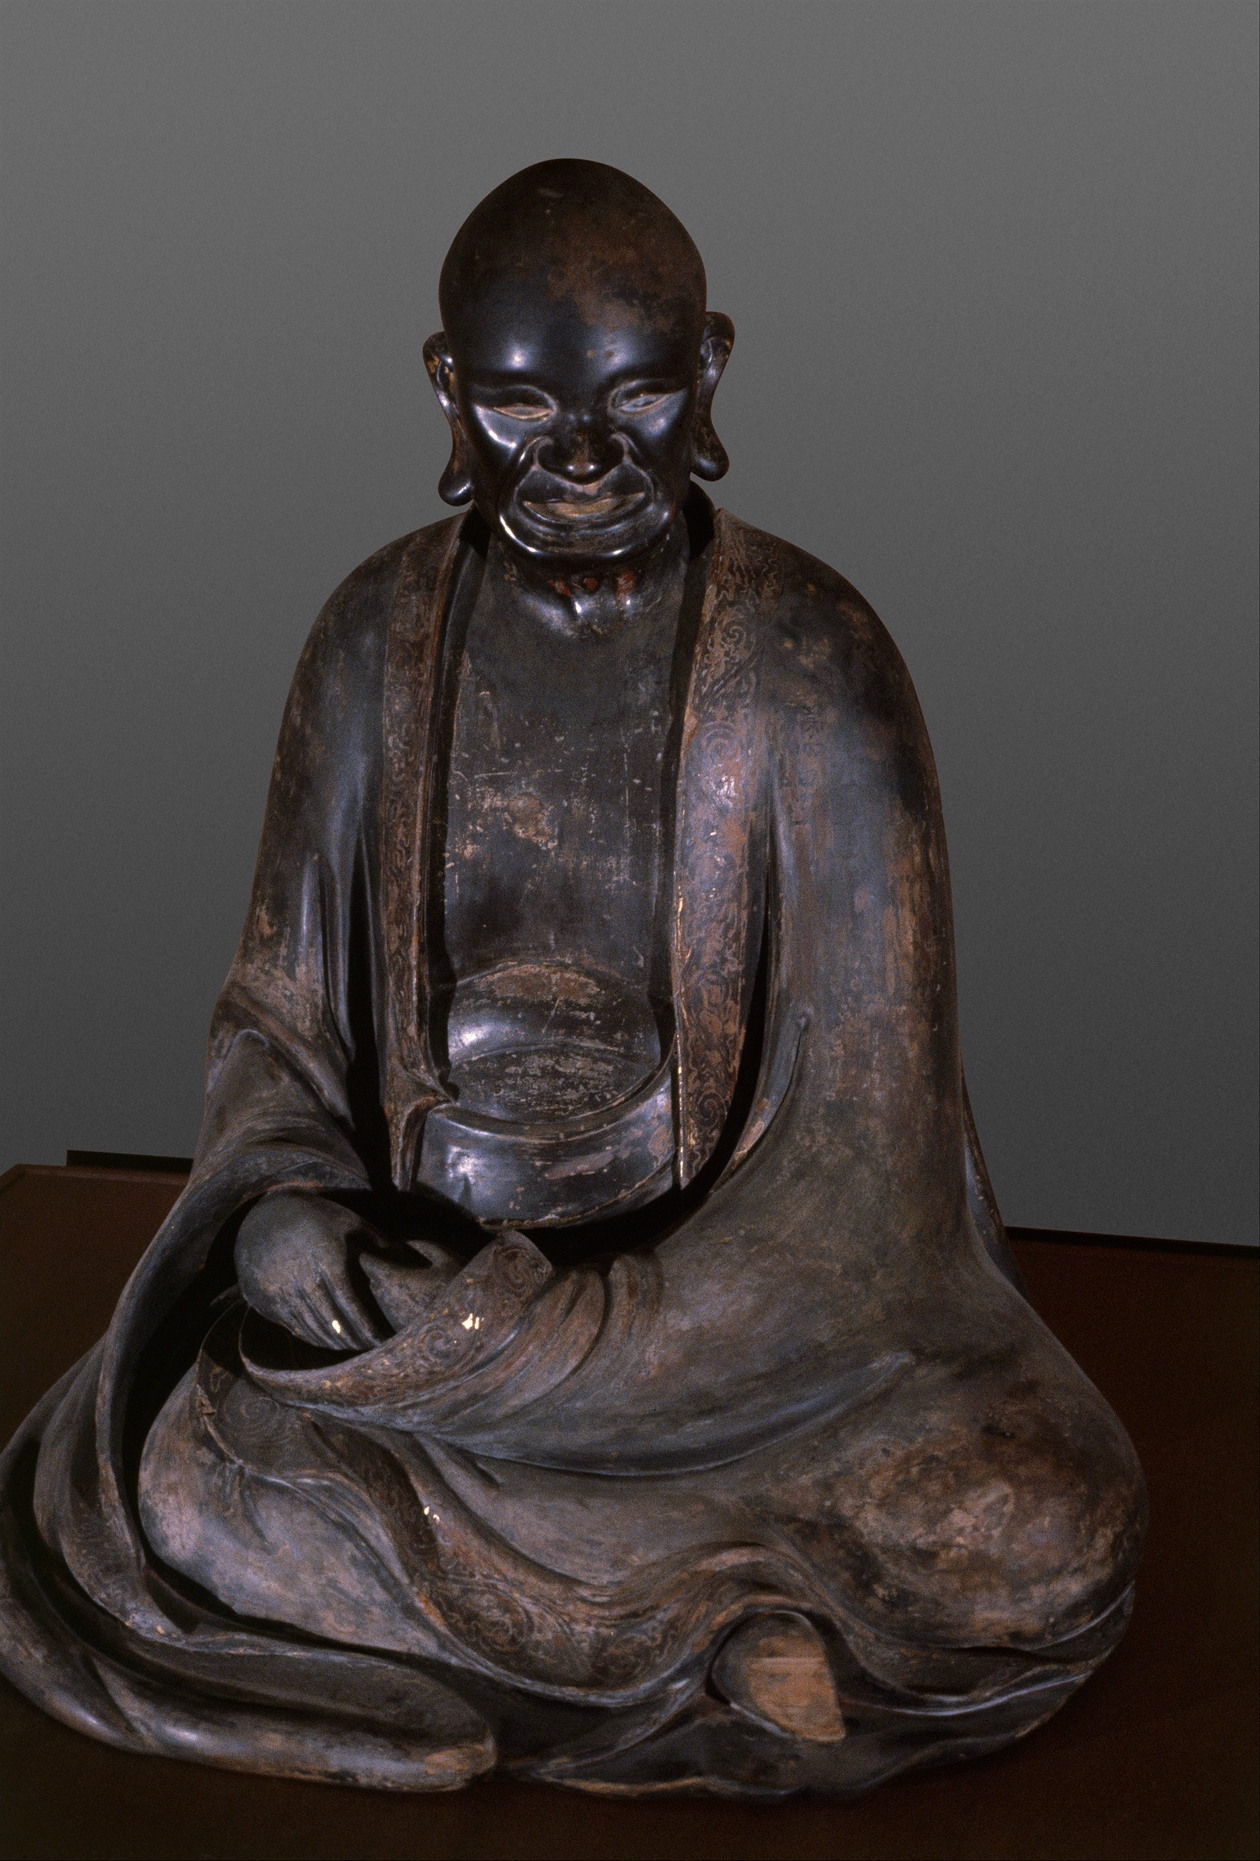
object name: figure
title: Seated Arhat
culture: japanese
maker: shōun genkei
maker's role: artist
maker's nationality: japanese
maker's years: 1648-1710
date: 1688-1695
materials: gold leaf, lacquer, wood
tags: men,buddhism